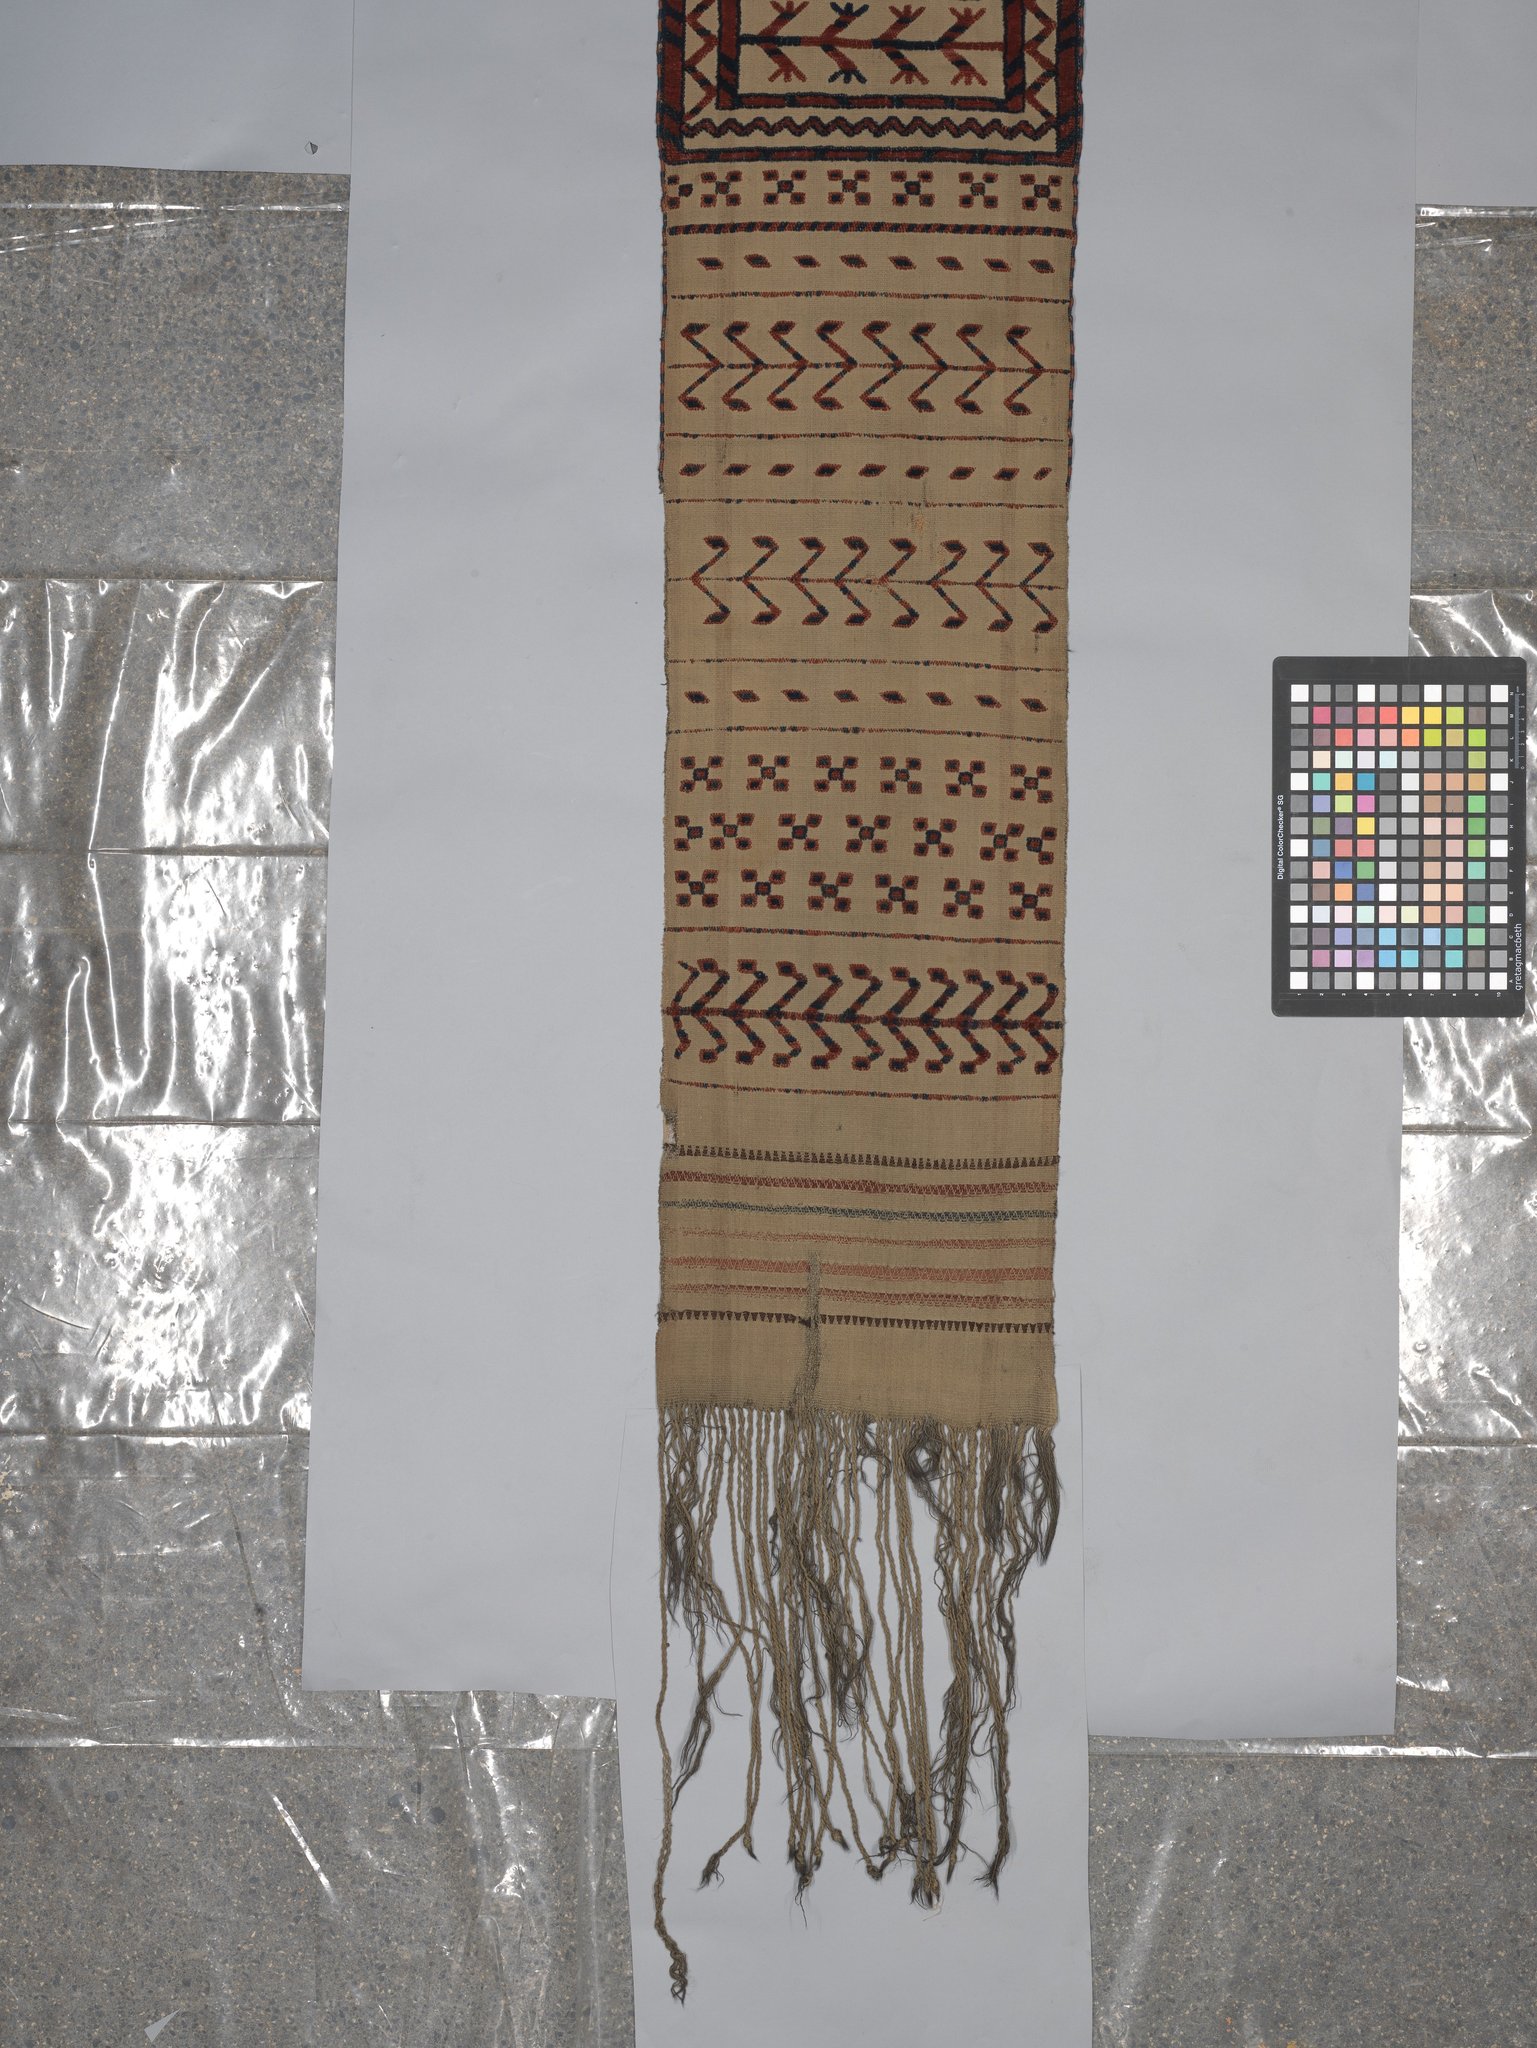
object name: tent band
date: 1801-1850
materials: wool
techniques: pile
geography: turkmenistan